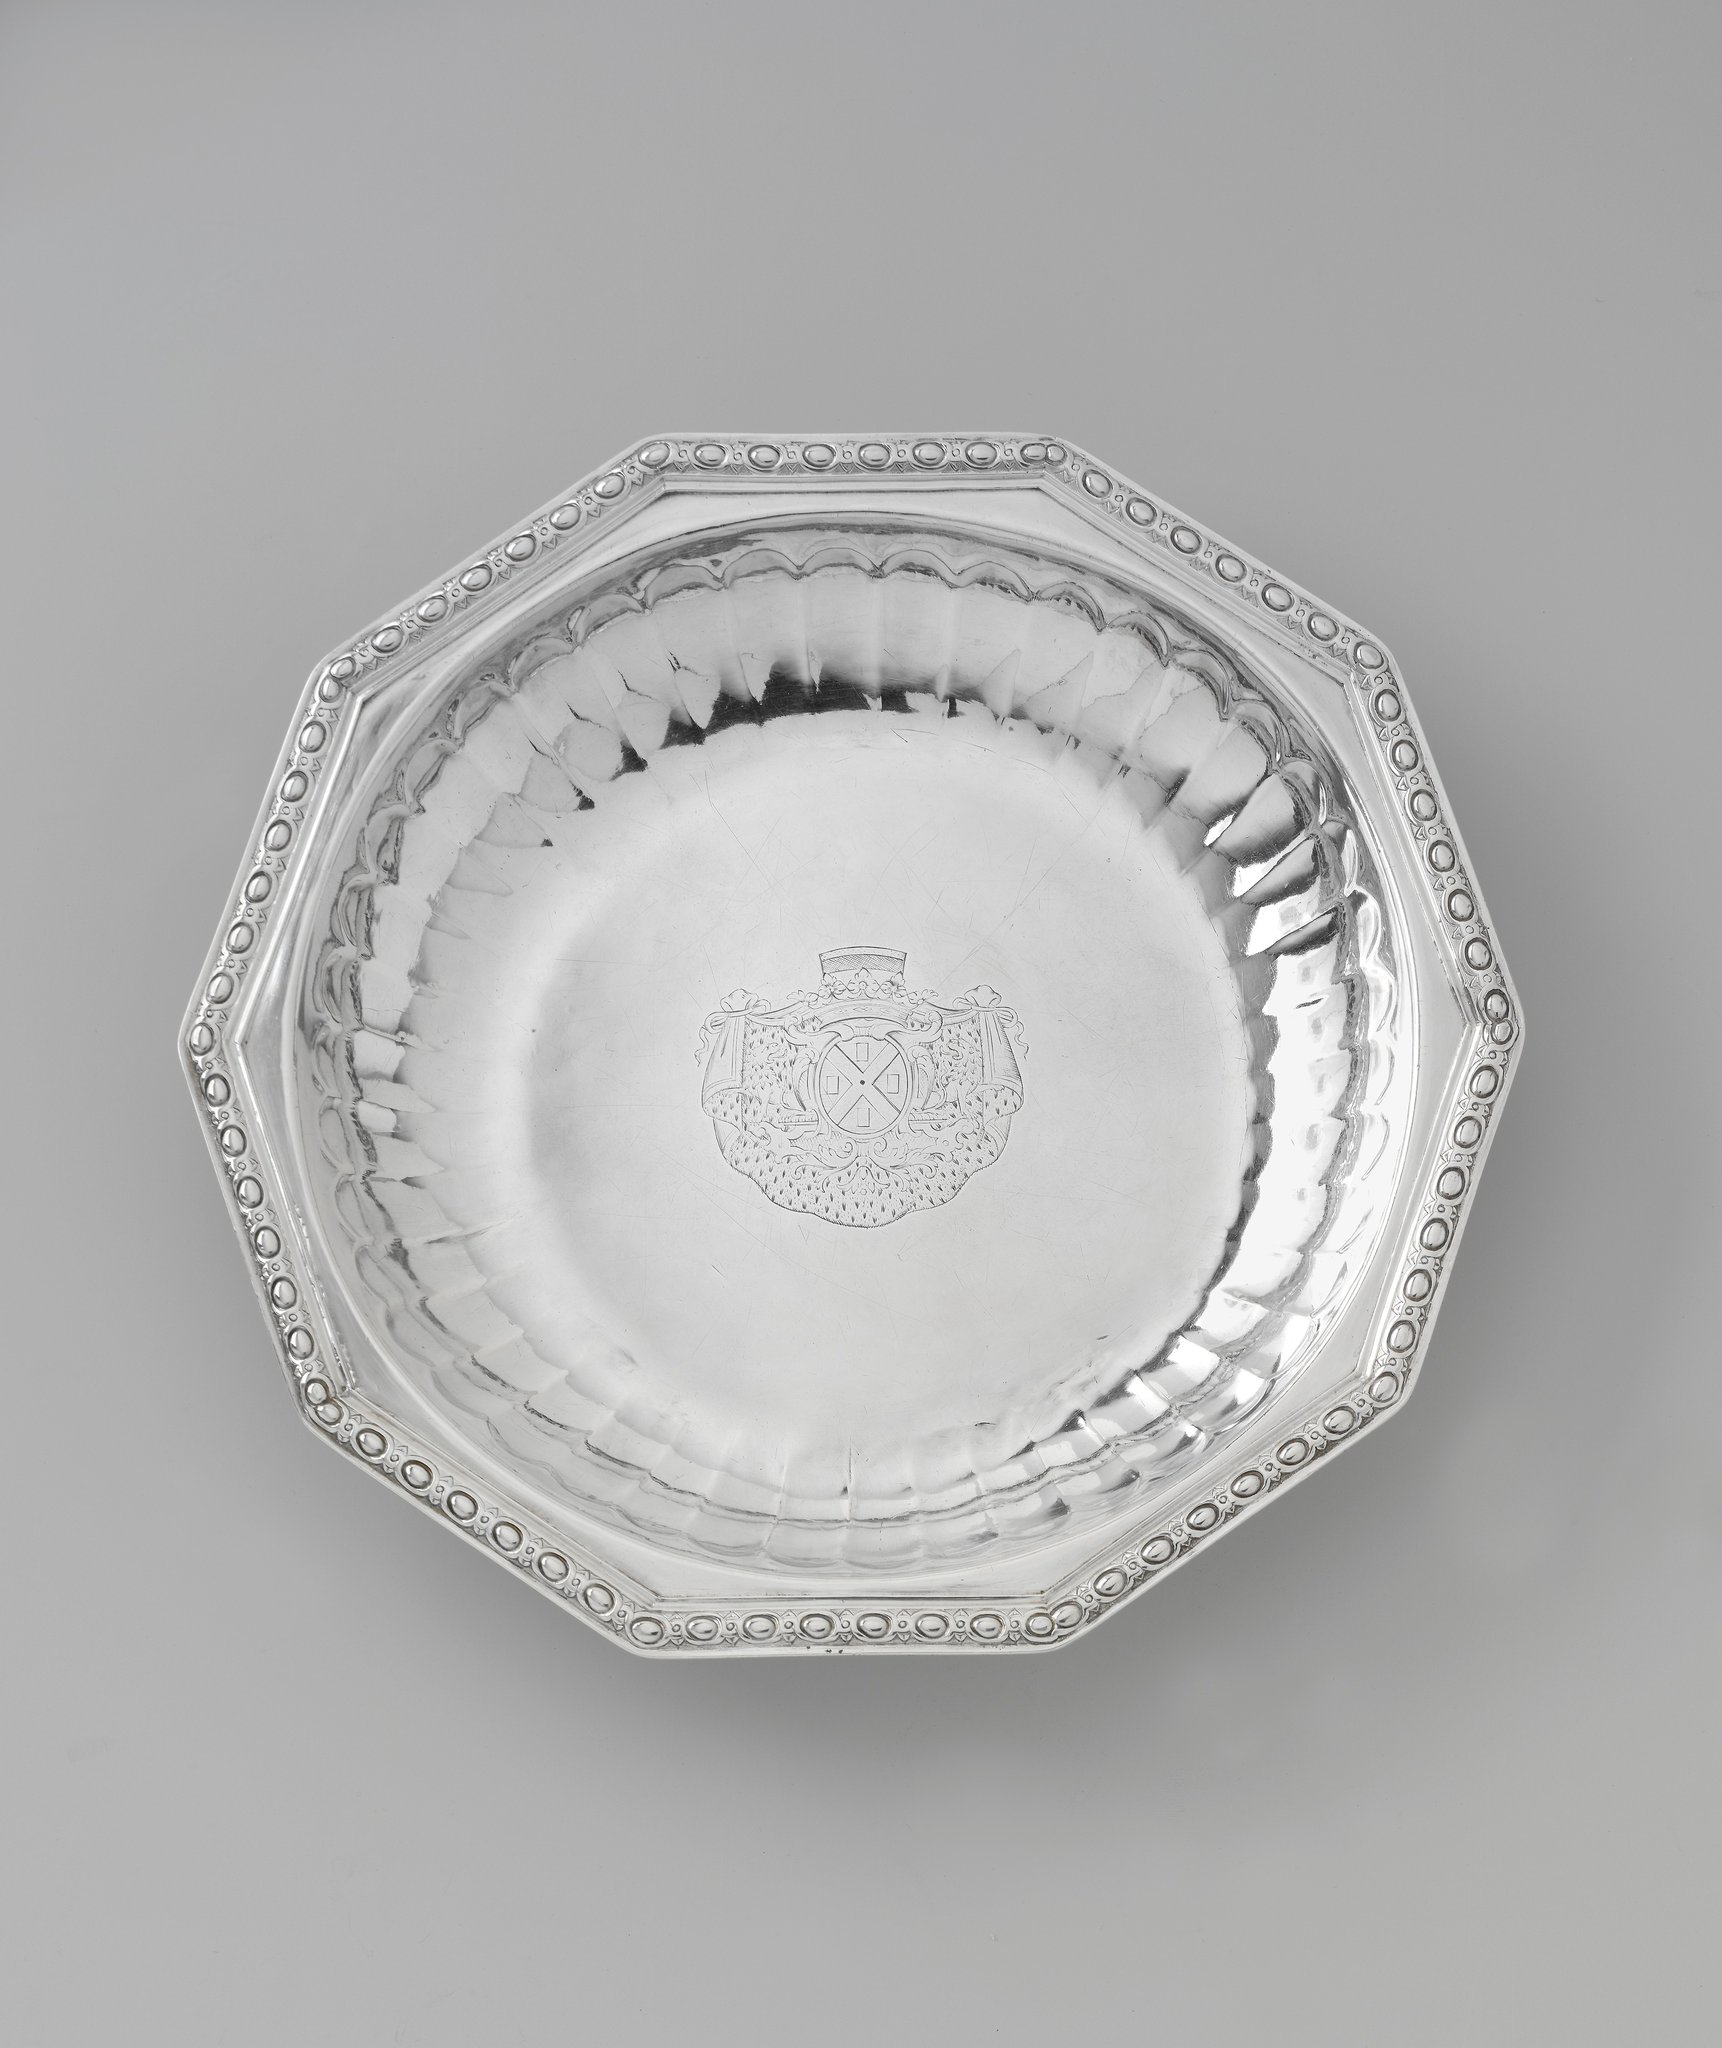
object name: dish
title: Dish (one of a pair)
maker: jean-baptiste i buchet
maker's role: maker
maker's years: 1694-1801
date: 1726-1728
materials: silver